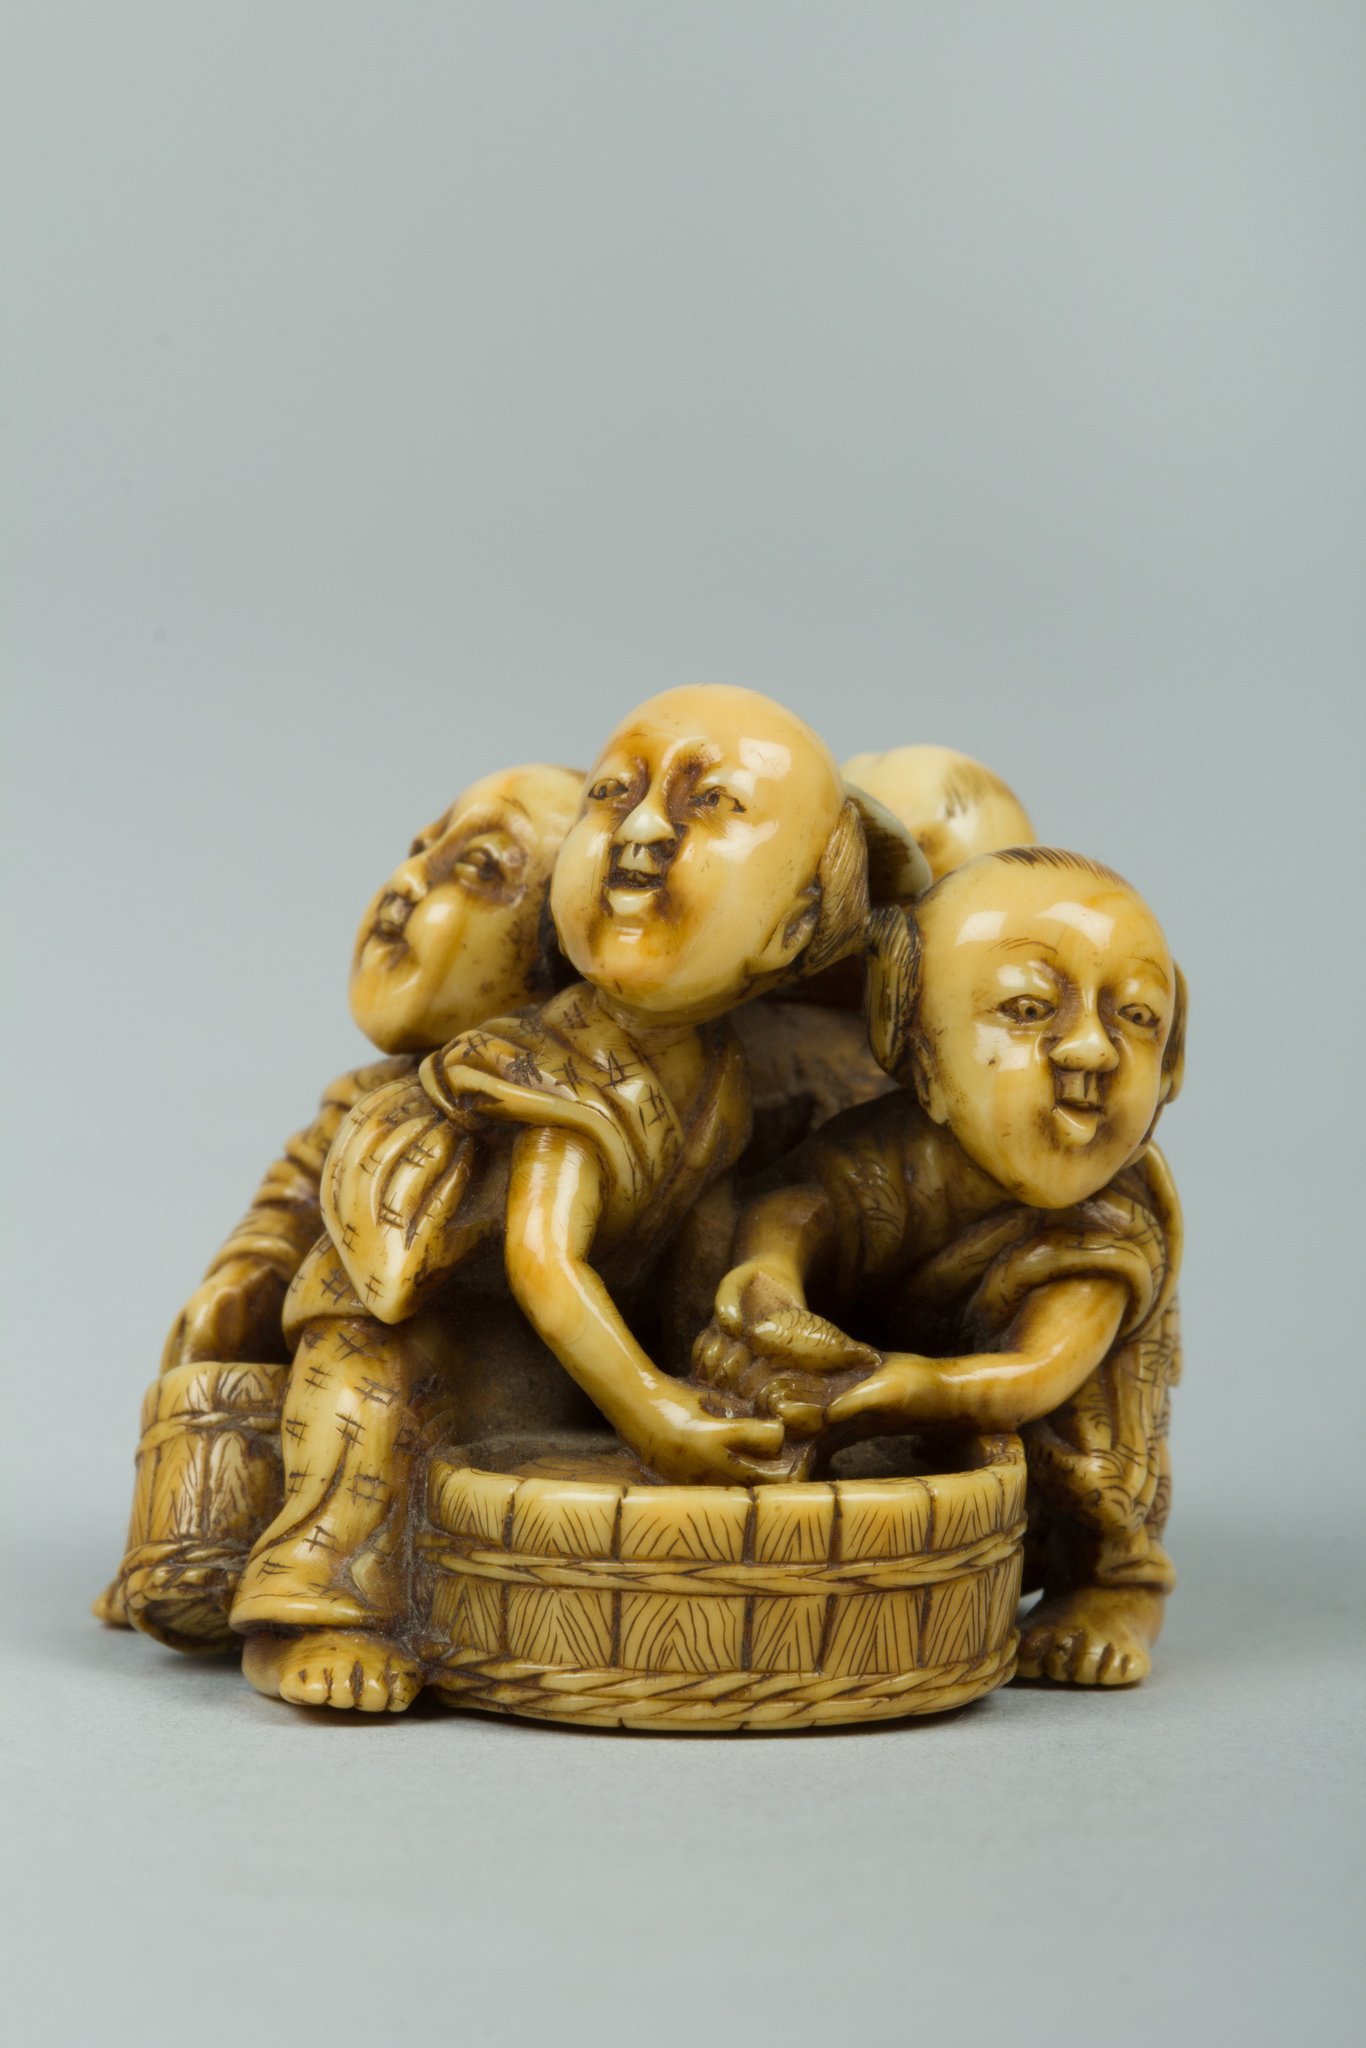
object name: netsuke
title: Netsuke of Group of Four Children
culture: japanese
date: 1801-1900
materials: ivory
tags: children